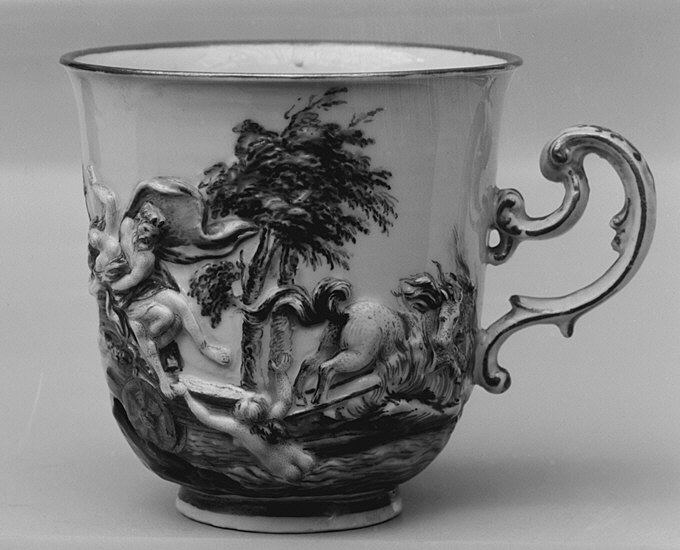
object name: coffee cup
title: Coffee cup (part of a service)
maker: doccia porcelain manufactory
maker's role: manufactory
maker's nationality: italian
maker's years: 1737-1896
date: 1760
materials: hard paste porcelain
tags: men,women,horses